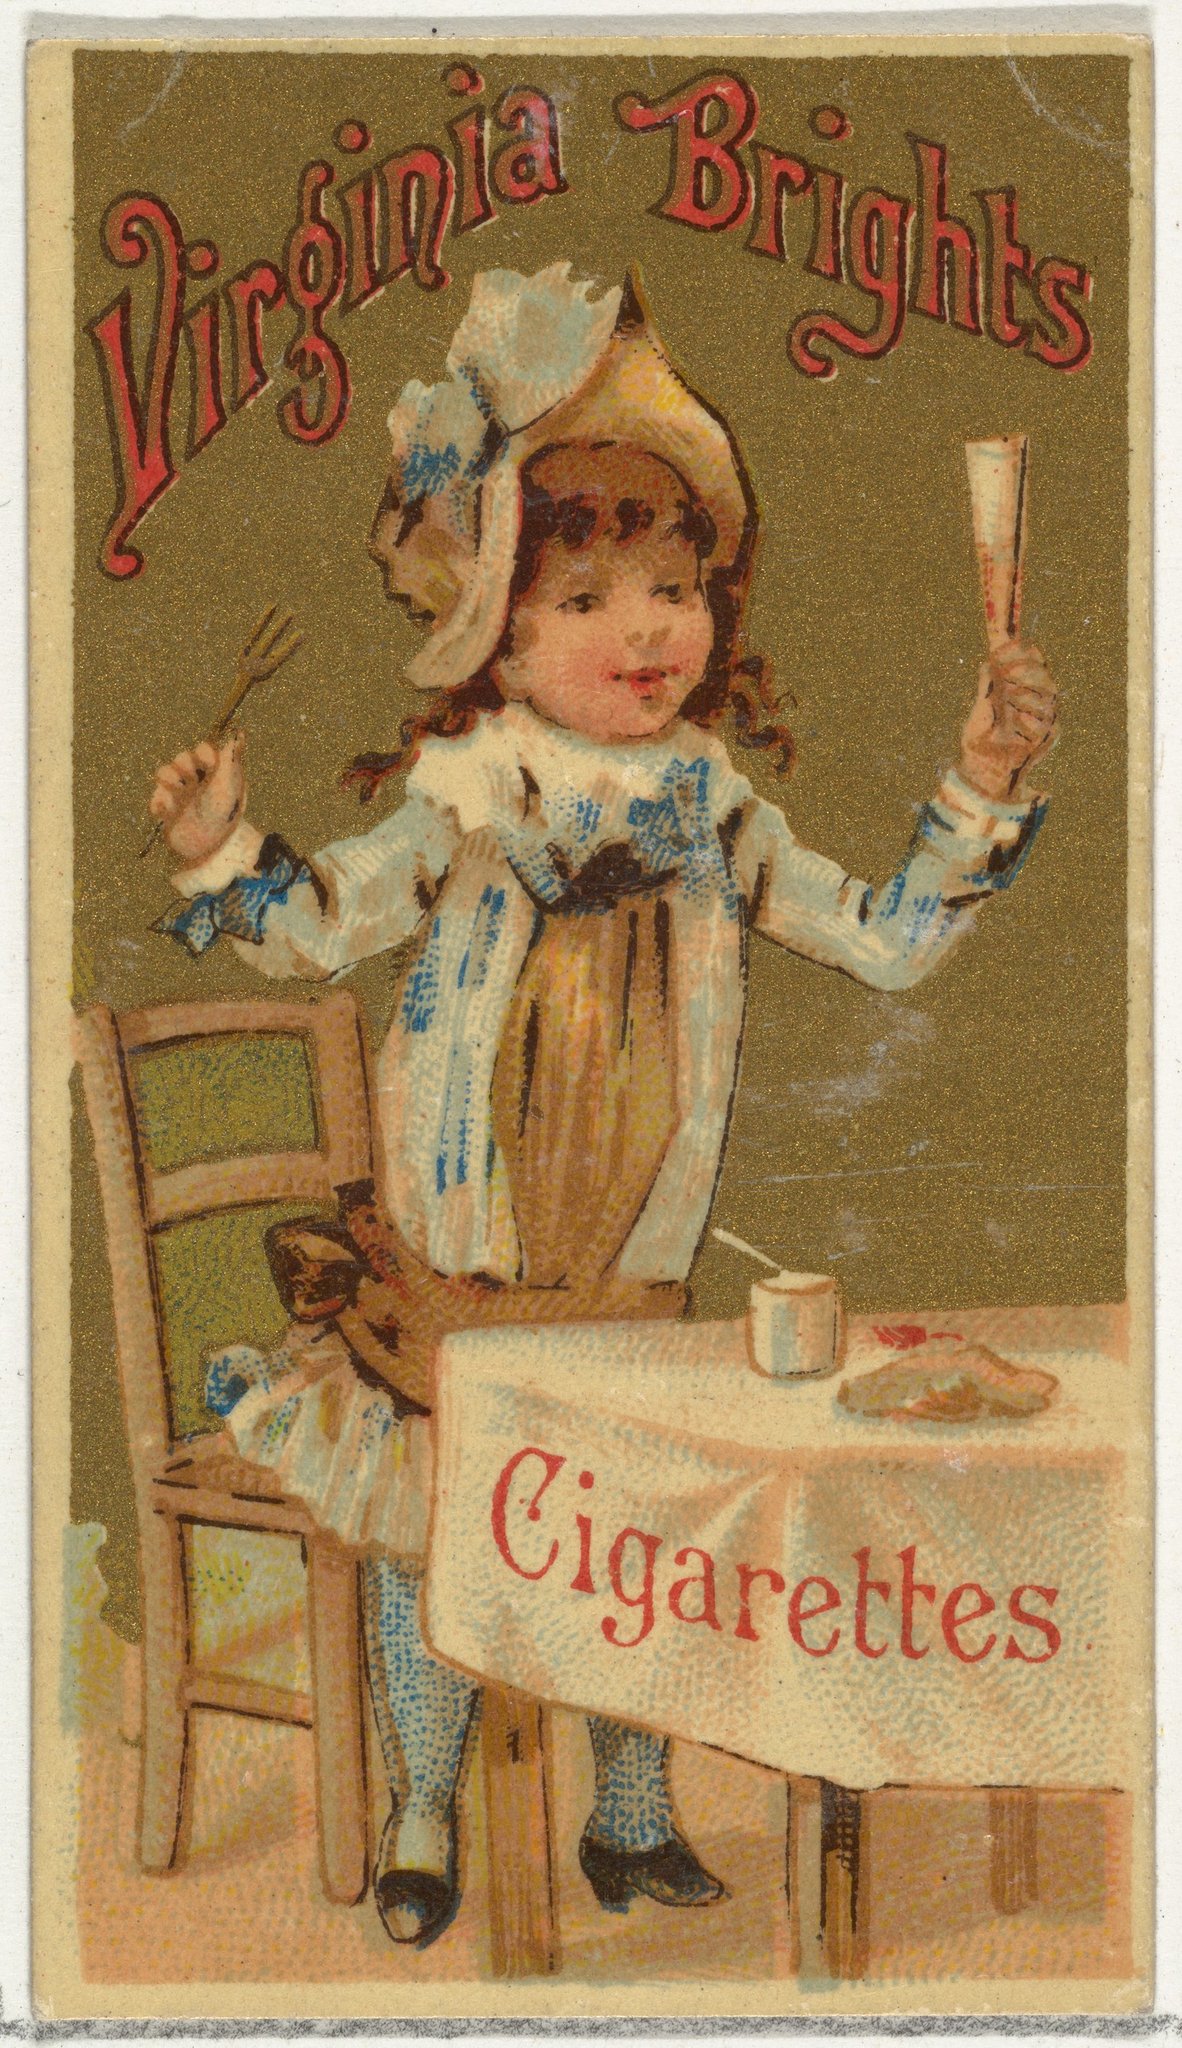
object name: print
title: From the Girls and Children series (N64) promoting Virginia Brights Cigarettes for Allen & Ginter brand tobacco products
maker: allen & ginter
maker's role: publisher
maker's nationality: american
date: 1886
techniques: color lithograph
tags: girls